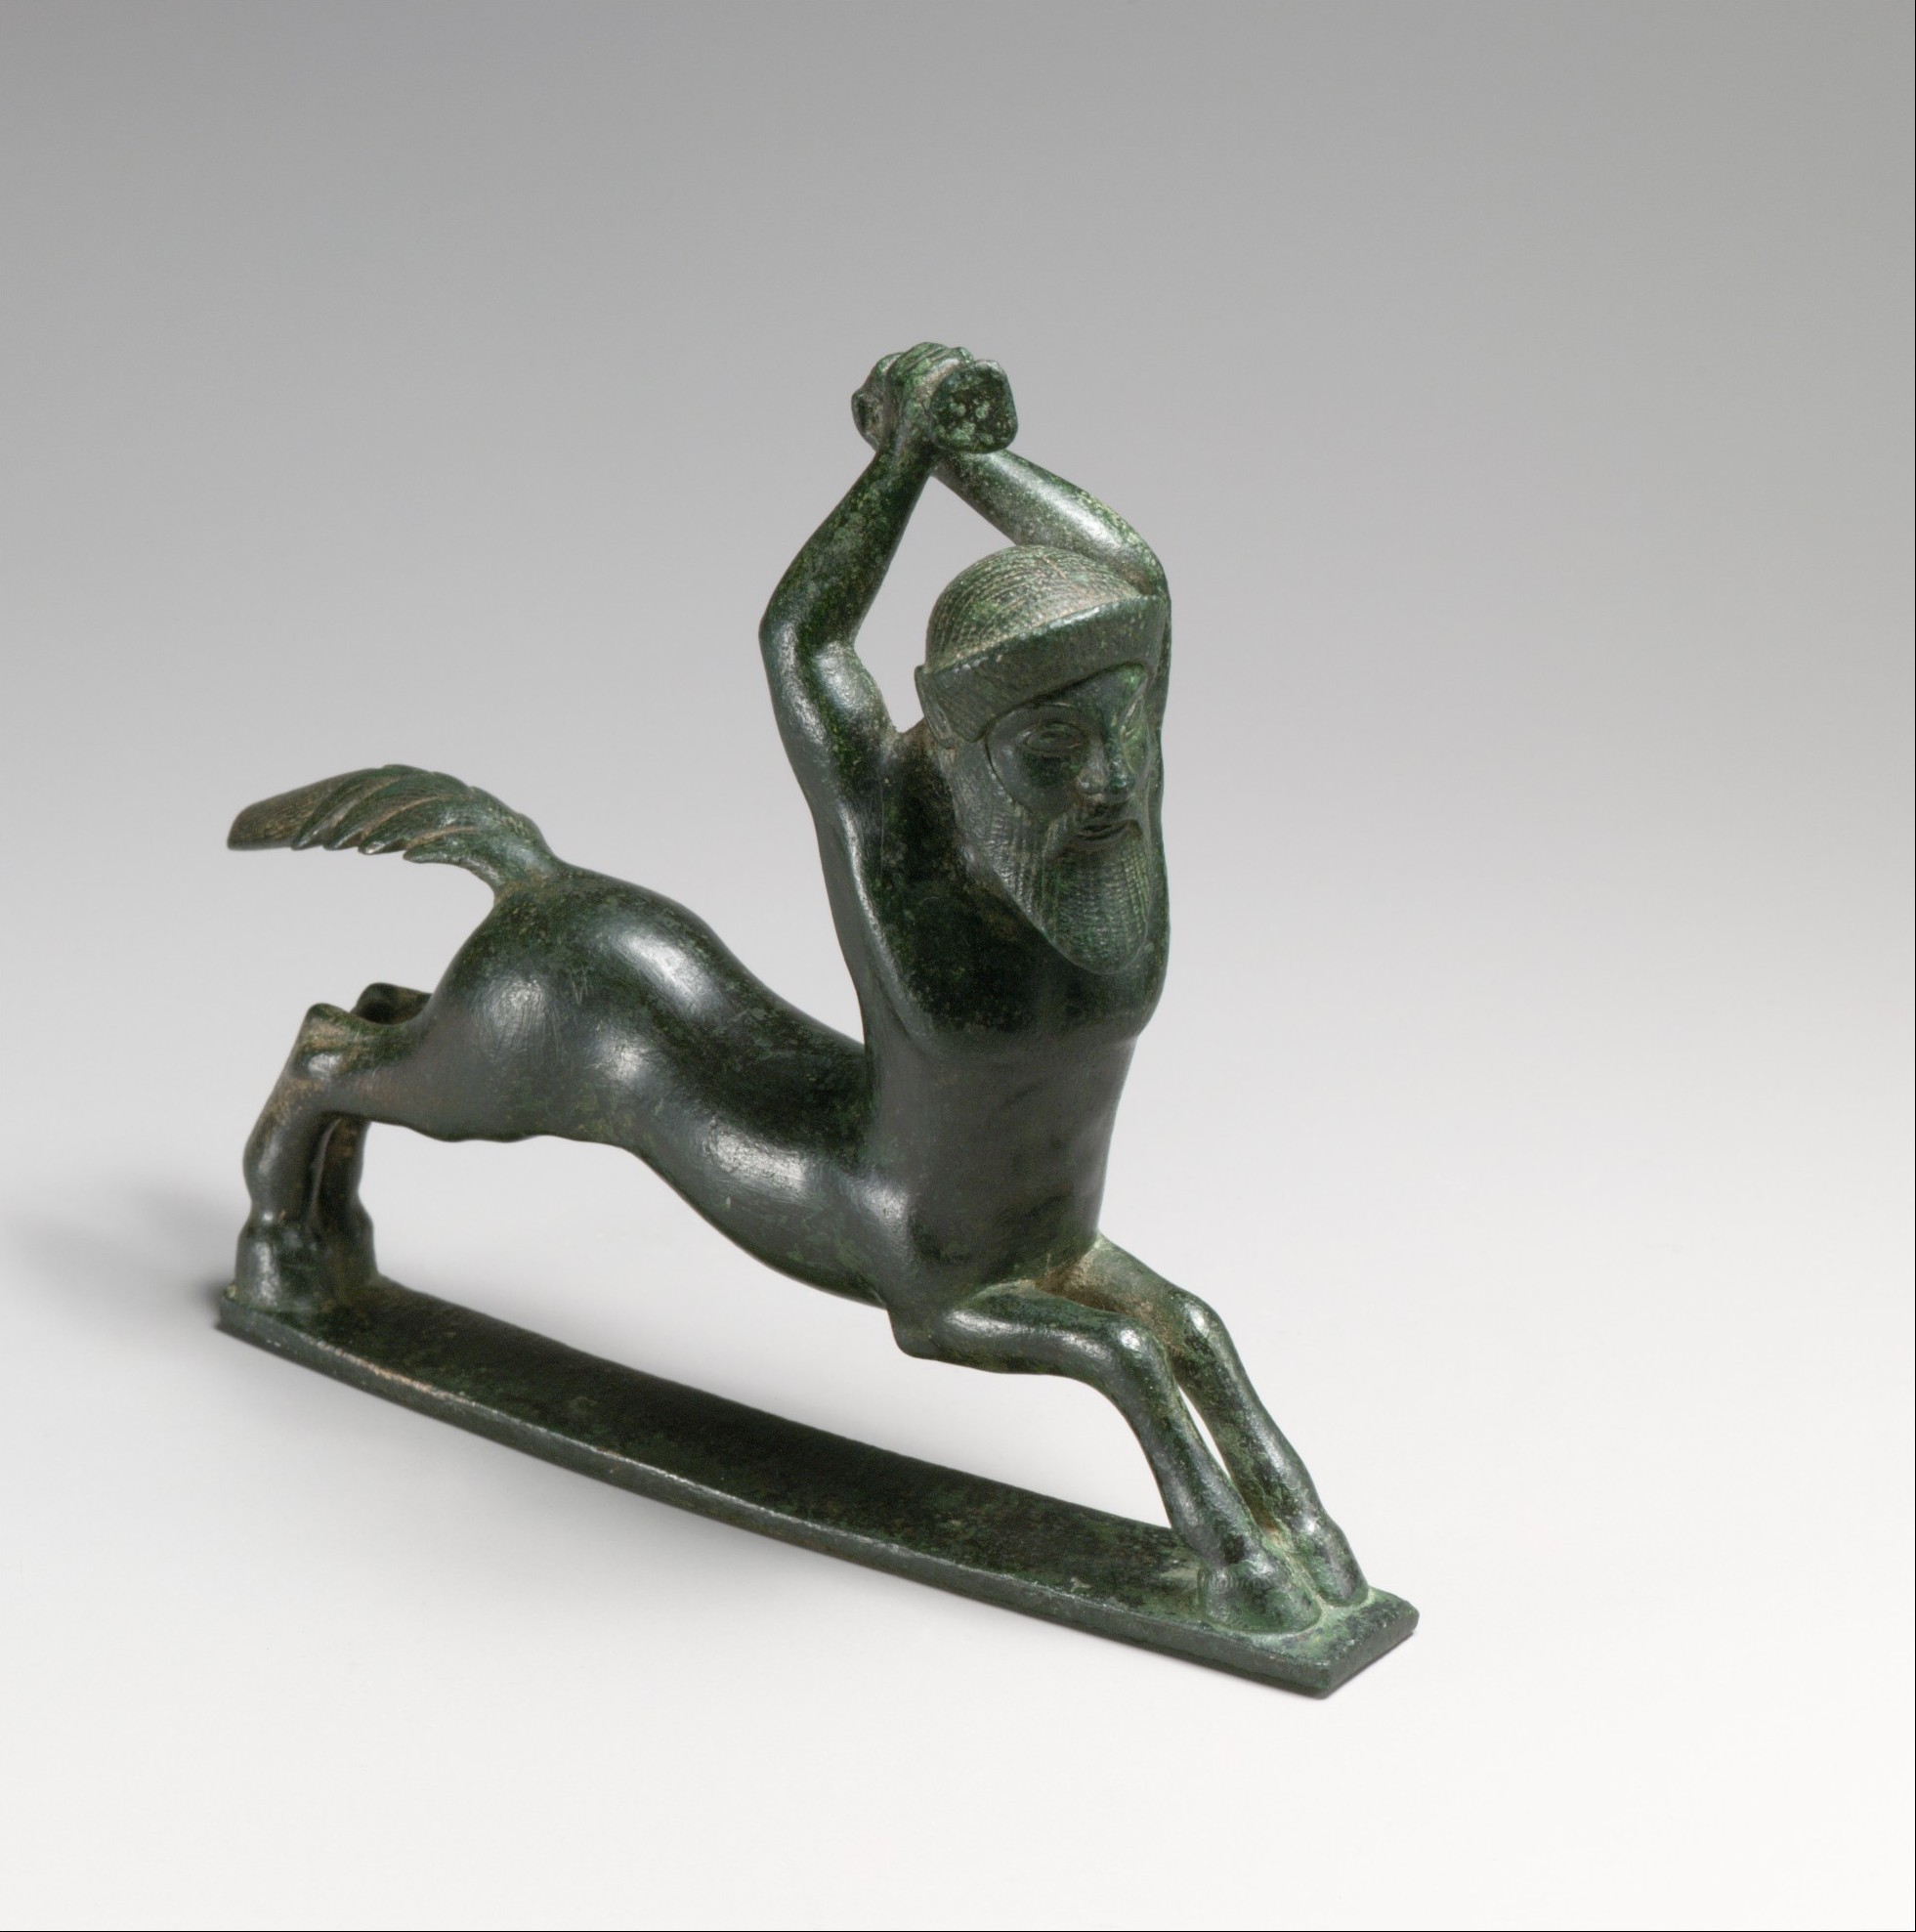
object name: statuette of a centaur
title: Bronze statuette of a centaur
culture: etruscan or italian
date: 534-468 BCE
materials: bronze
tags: centaurs